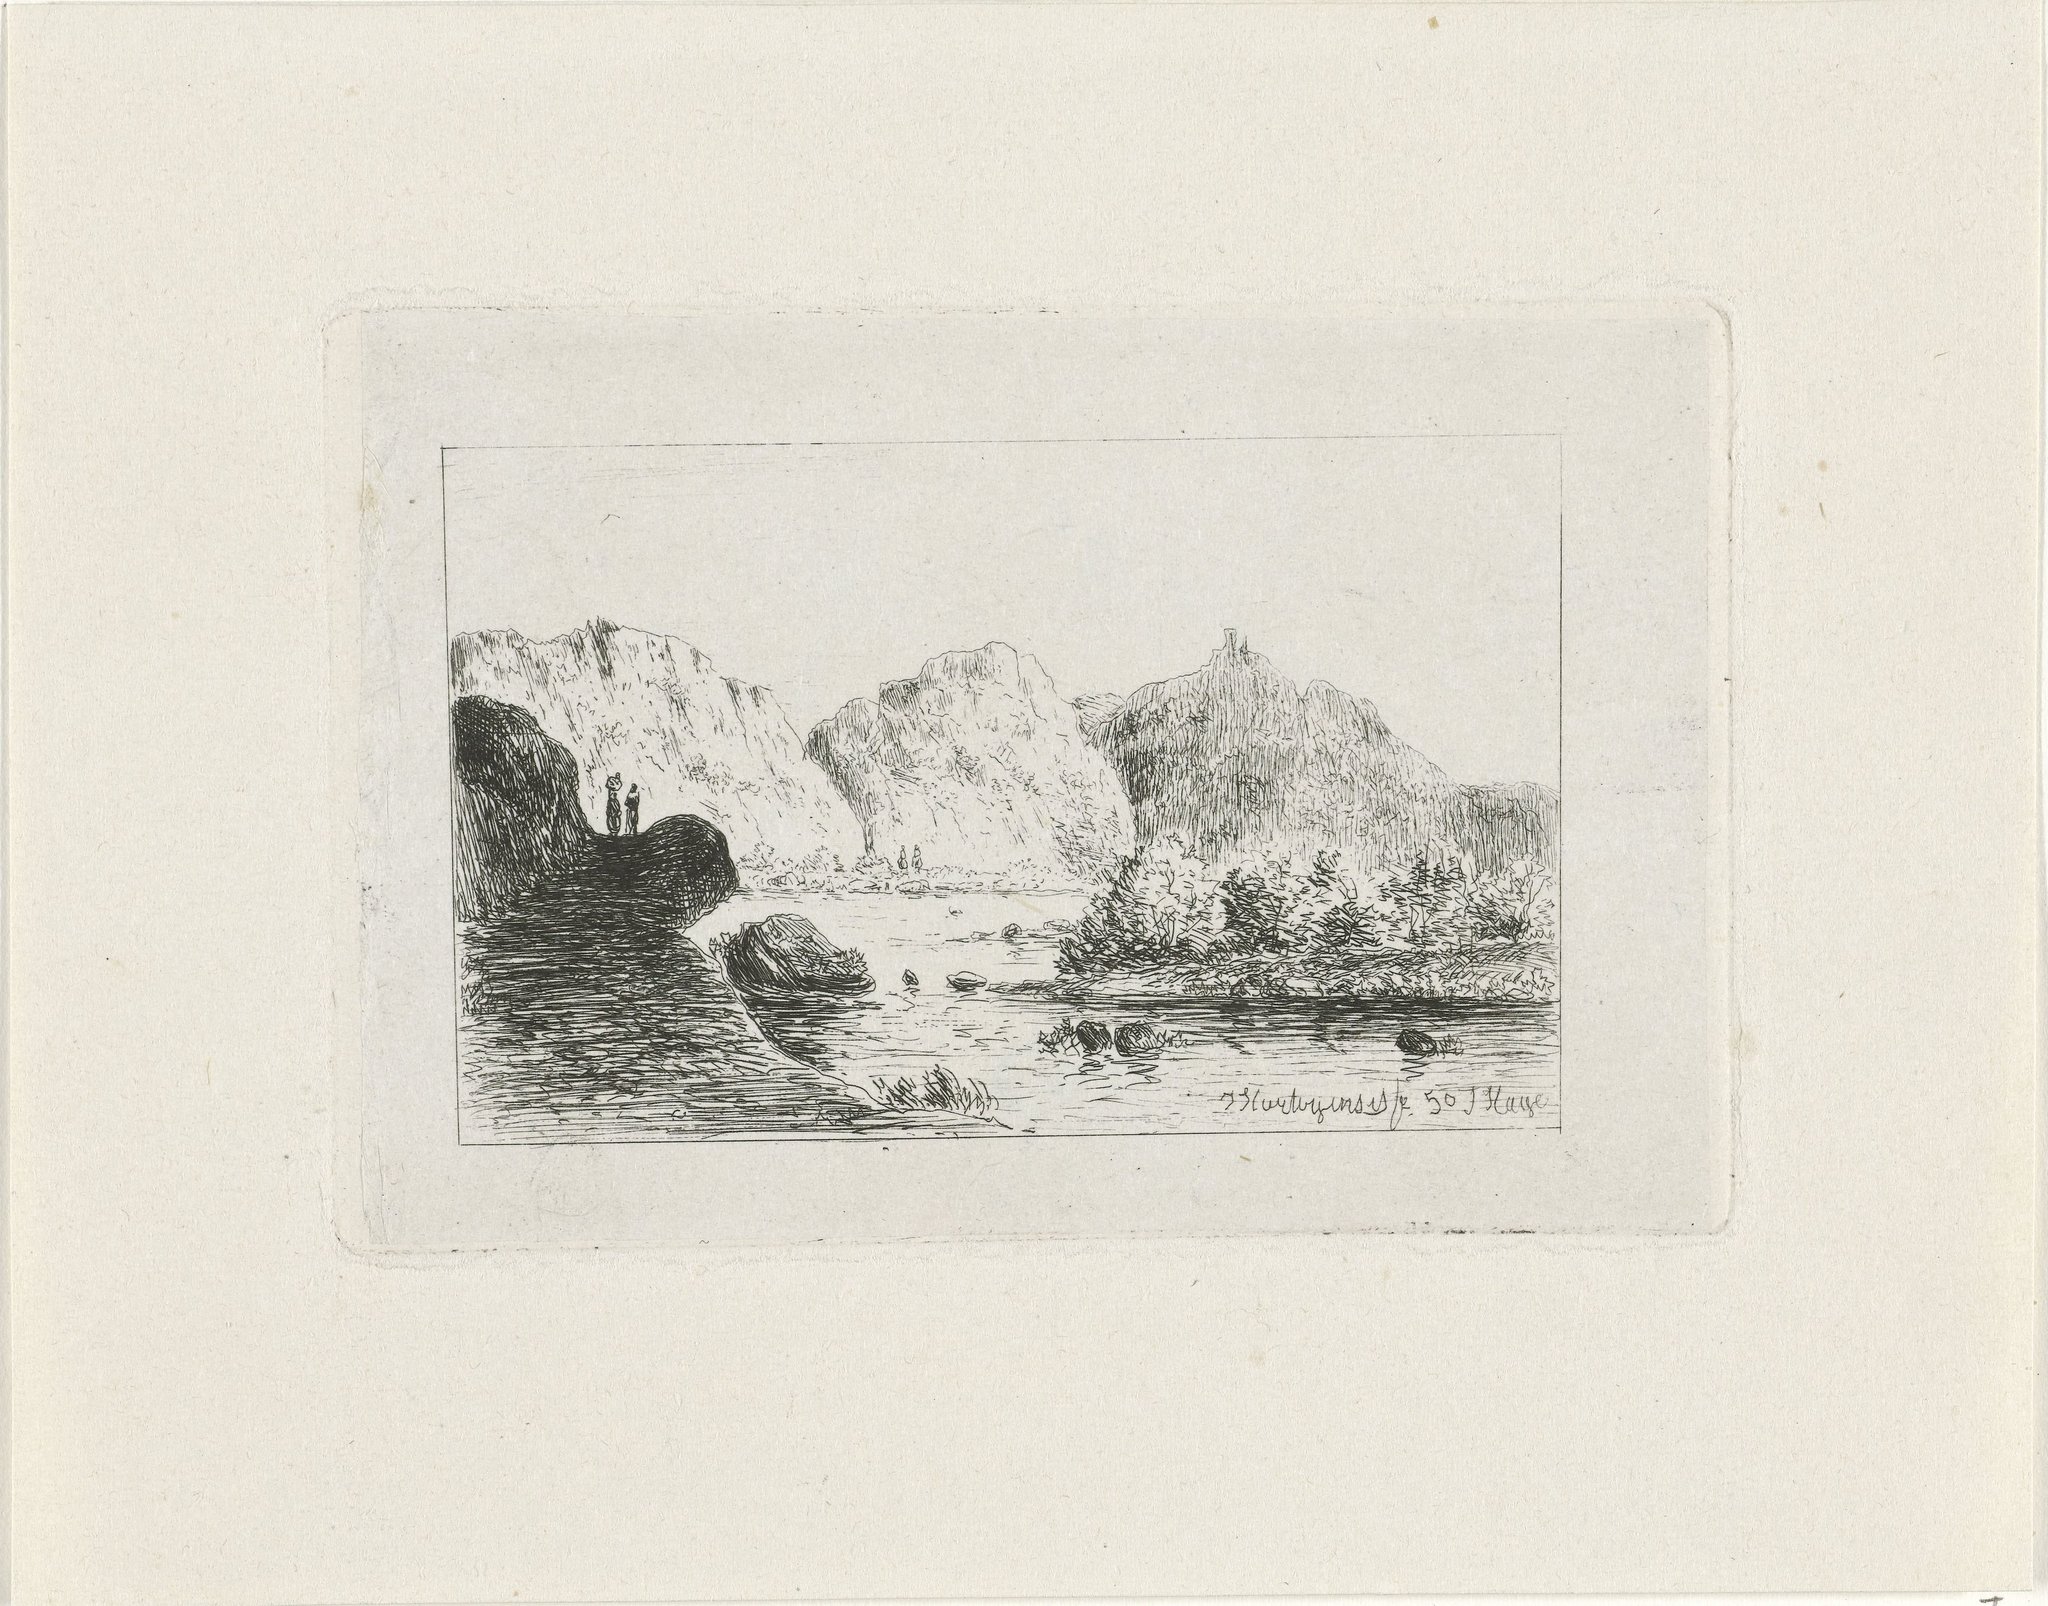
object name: print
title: Berglandschap aan de Aar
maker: joseph hartogensis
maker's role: painter, print maker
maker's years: 1822-1865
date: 1850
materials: paper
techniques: etching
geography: dusseldorf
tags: mountains (+ landscape with figures, staffage), landscapes with waters, waterscapes, seascapes (in the temperate zone) (+ landscape with figures, staffage)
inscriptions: collector's mark: Lugt 2228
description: Een bergachtig landschap met een rivier, met links op de voorgrond twee figuren op een rots. Aan de overzijde van de rivier hoge bergen.